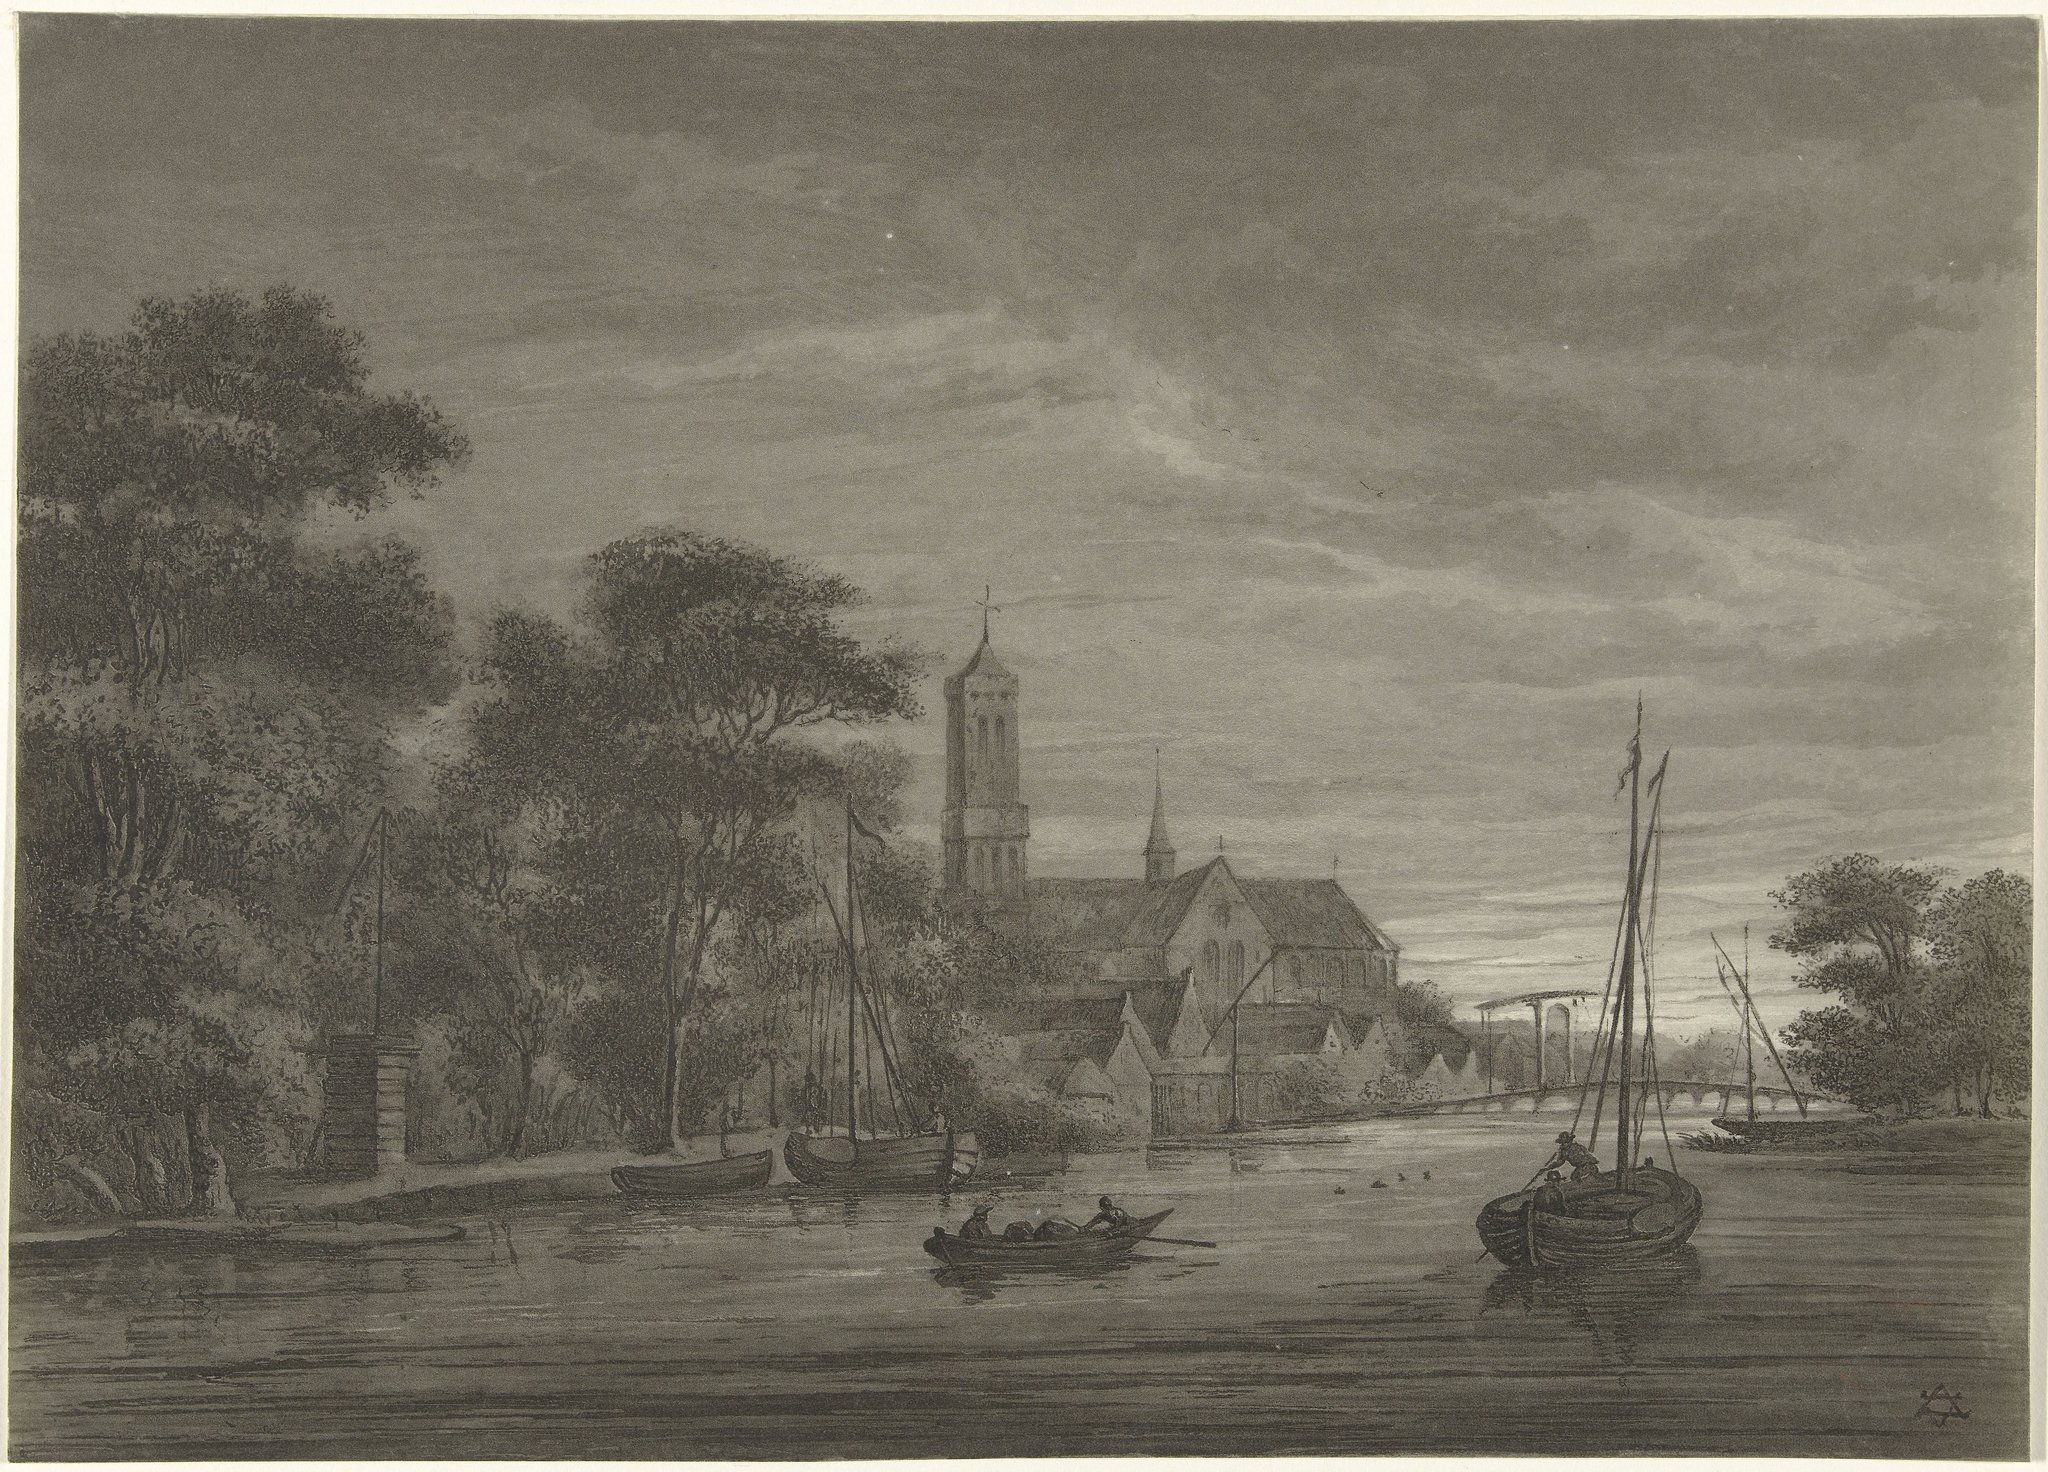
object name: print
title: Nachtlandschap met gezicht op dorp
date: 1821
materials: paper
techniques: aquatint, etching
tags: night ~ landscape (sometimes titled 'nox')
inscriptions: collector's mark: Lugt 2725, collector's mark: Lugt 12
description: Door Christiaan Josi opgenomen in een uitgave met 100 werken naar Hollandse en Vlaamse meesters: Collection d'imitations de dessins d'après les principaux maîtres hollandais et flamands, Londen, C.Josi, 1821. Alle prenten in deze uitgave dragen op het verso het wapen van Cornelis Ploos van Amstel, de initiatiefnemer voor de uitgave.